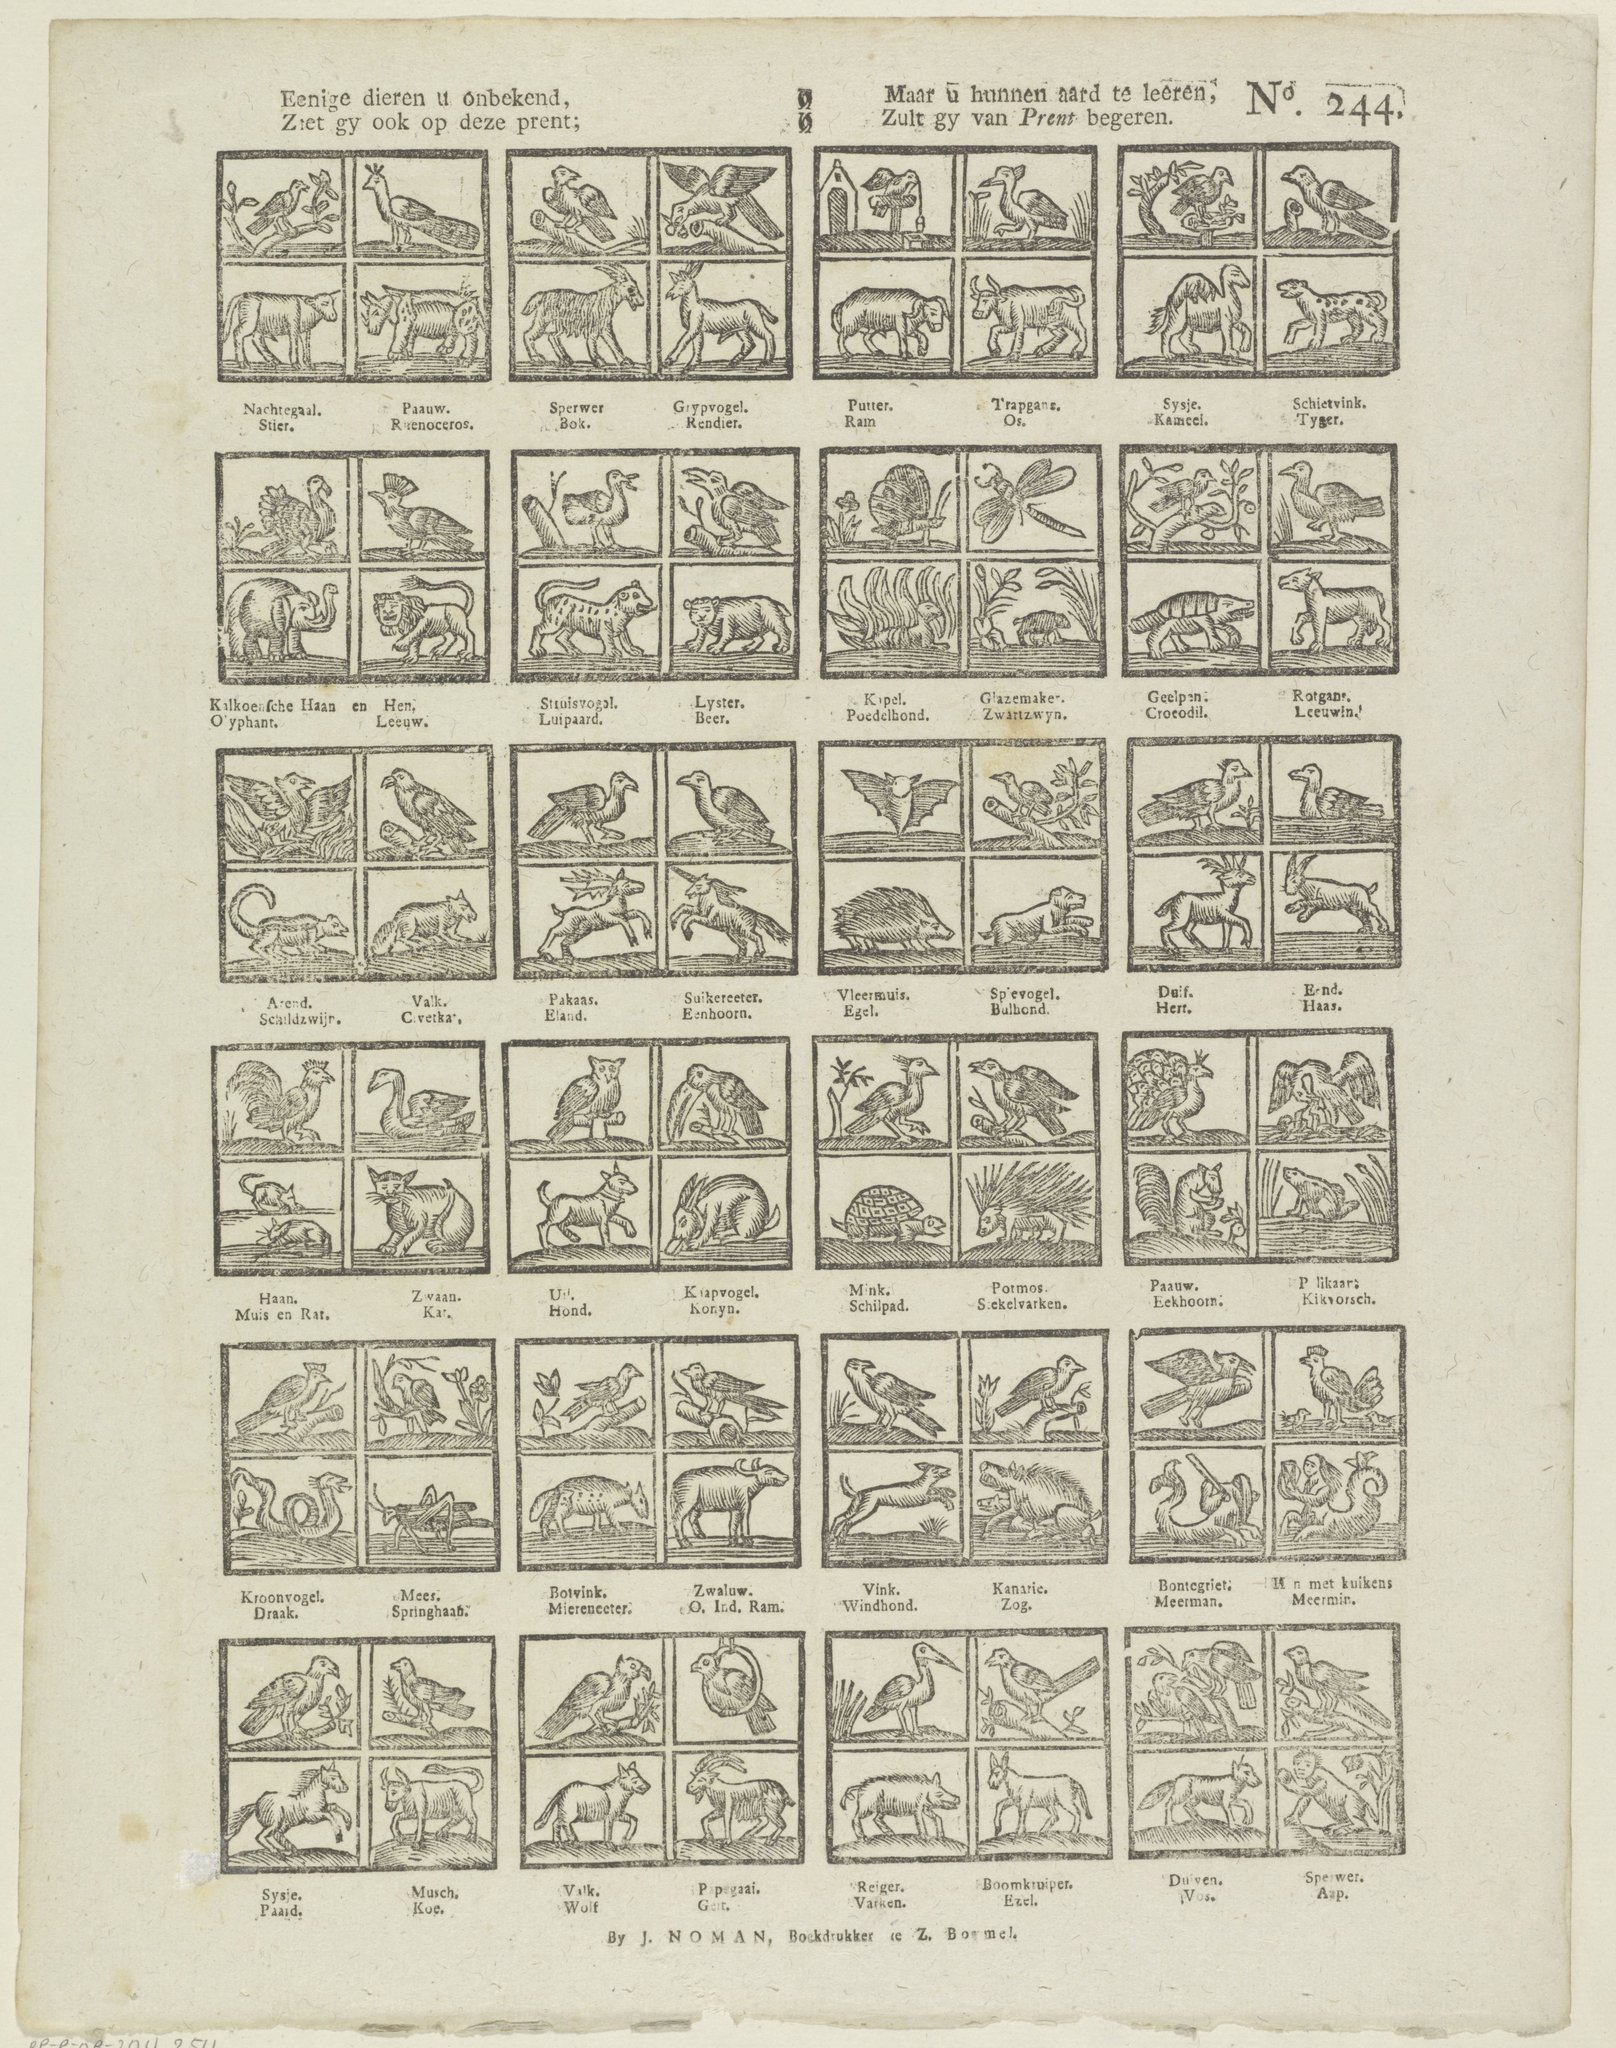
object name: print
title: Eenige dieren u bekend, / Ziet gy ook op deze prent; / Maar u hunnen aard te leêren, / Zult gy van prent begeren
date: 1806-1830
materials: paper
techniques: letterpress printing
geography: zaltbommel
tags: mammals, animals, birds, rodents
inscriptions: collector's mark: Lugt 2760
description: Blad met 24 voorstellingen van telkens vier dieren, zoals vogels, knaagdieren en boerderijdieren. Onder elke afbeelding de namen van de afgebeelde dieren. Genummerd rechtsboven: No. 244.